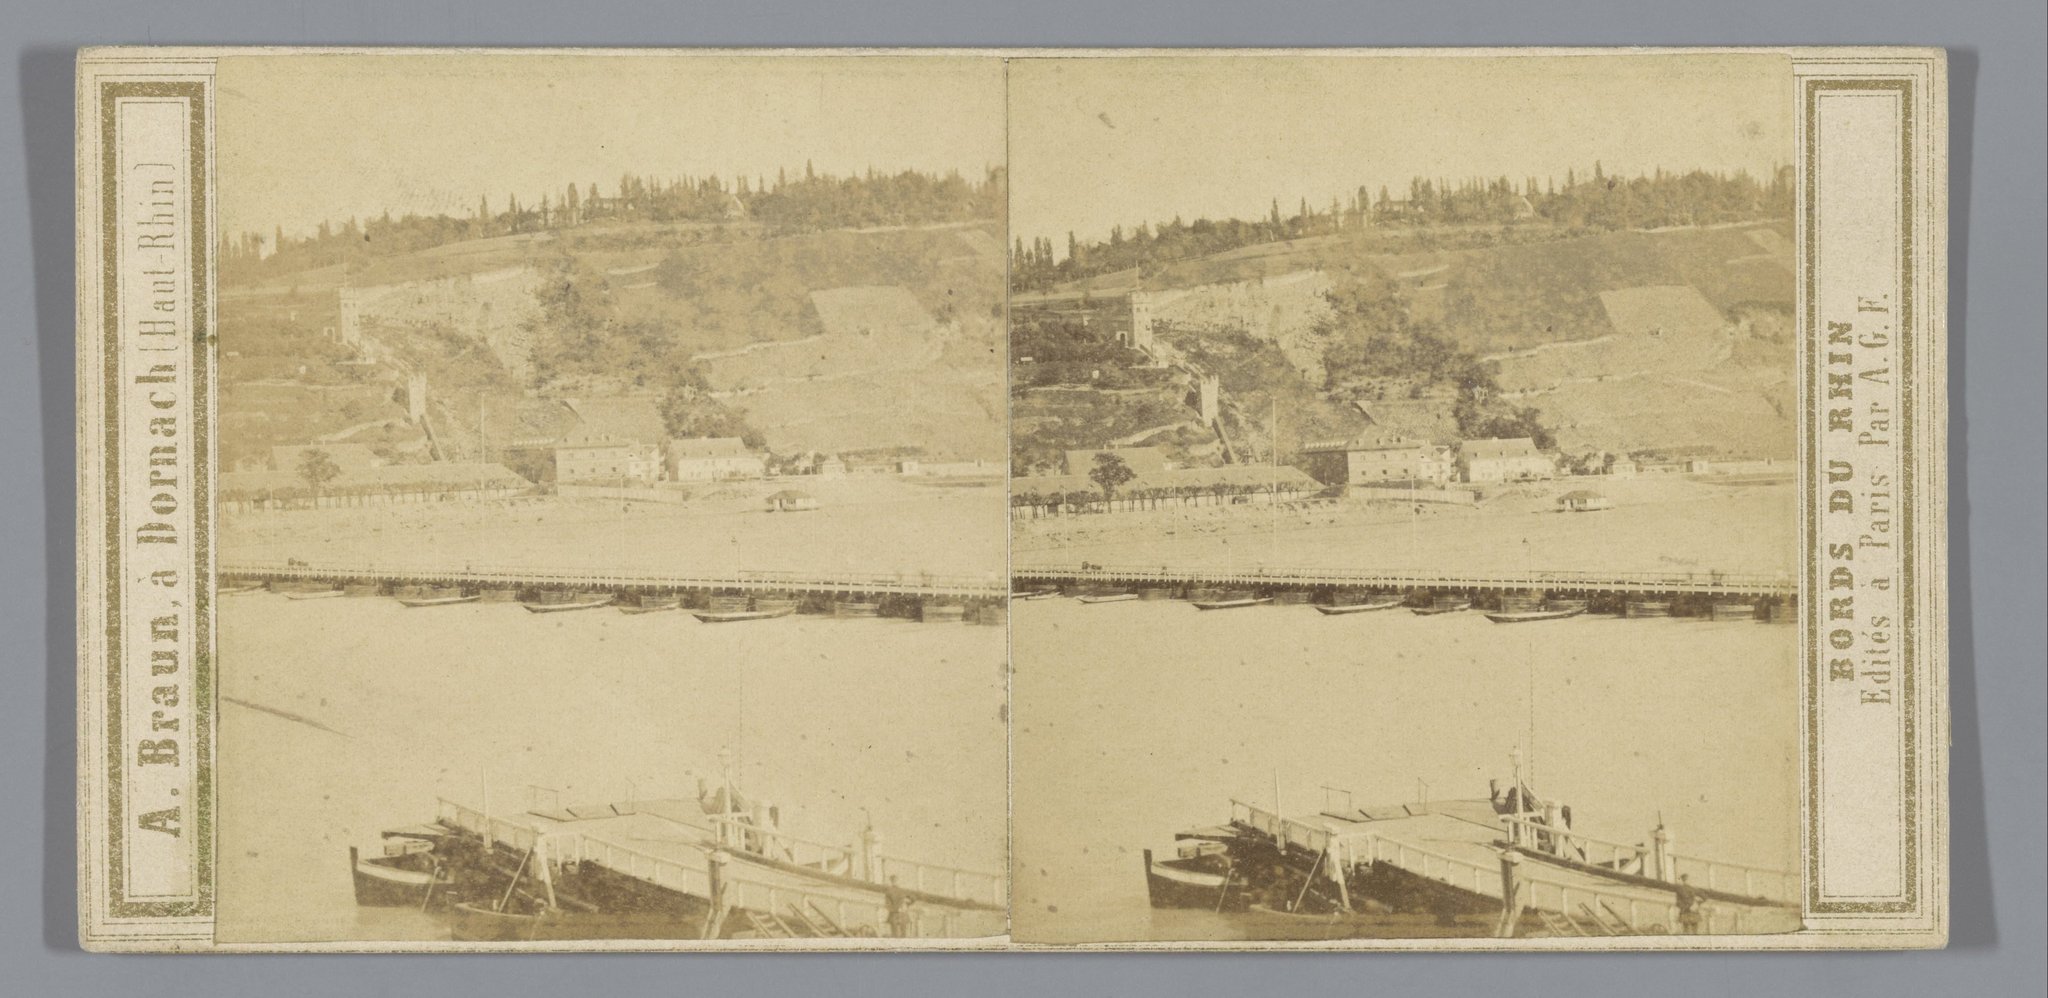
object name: stereograph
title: Bords du Rhin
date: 1860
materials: cardboard, paper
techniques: albumen print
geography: koblenz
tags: bridge in city across river, canal, etc.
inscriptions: number: ‘819.’